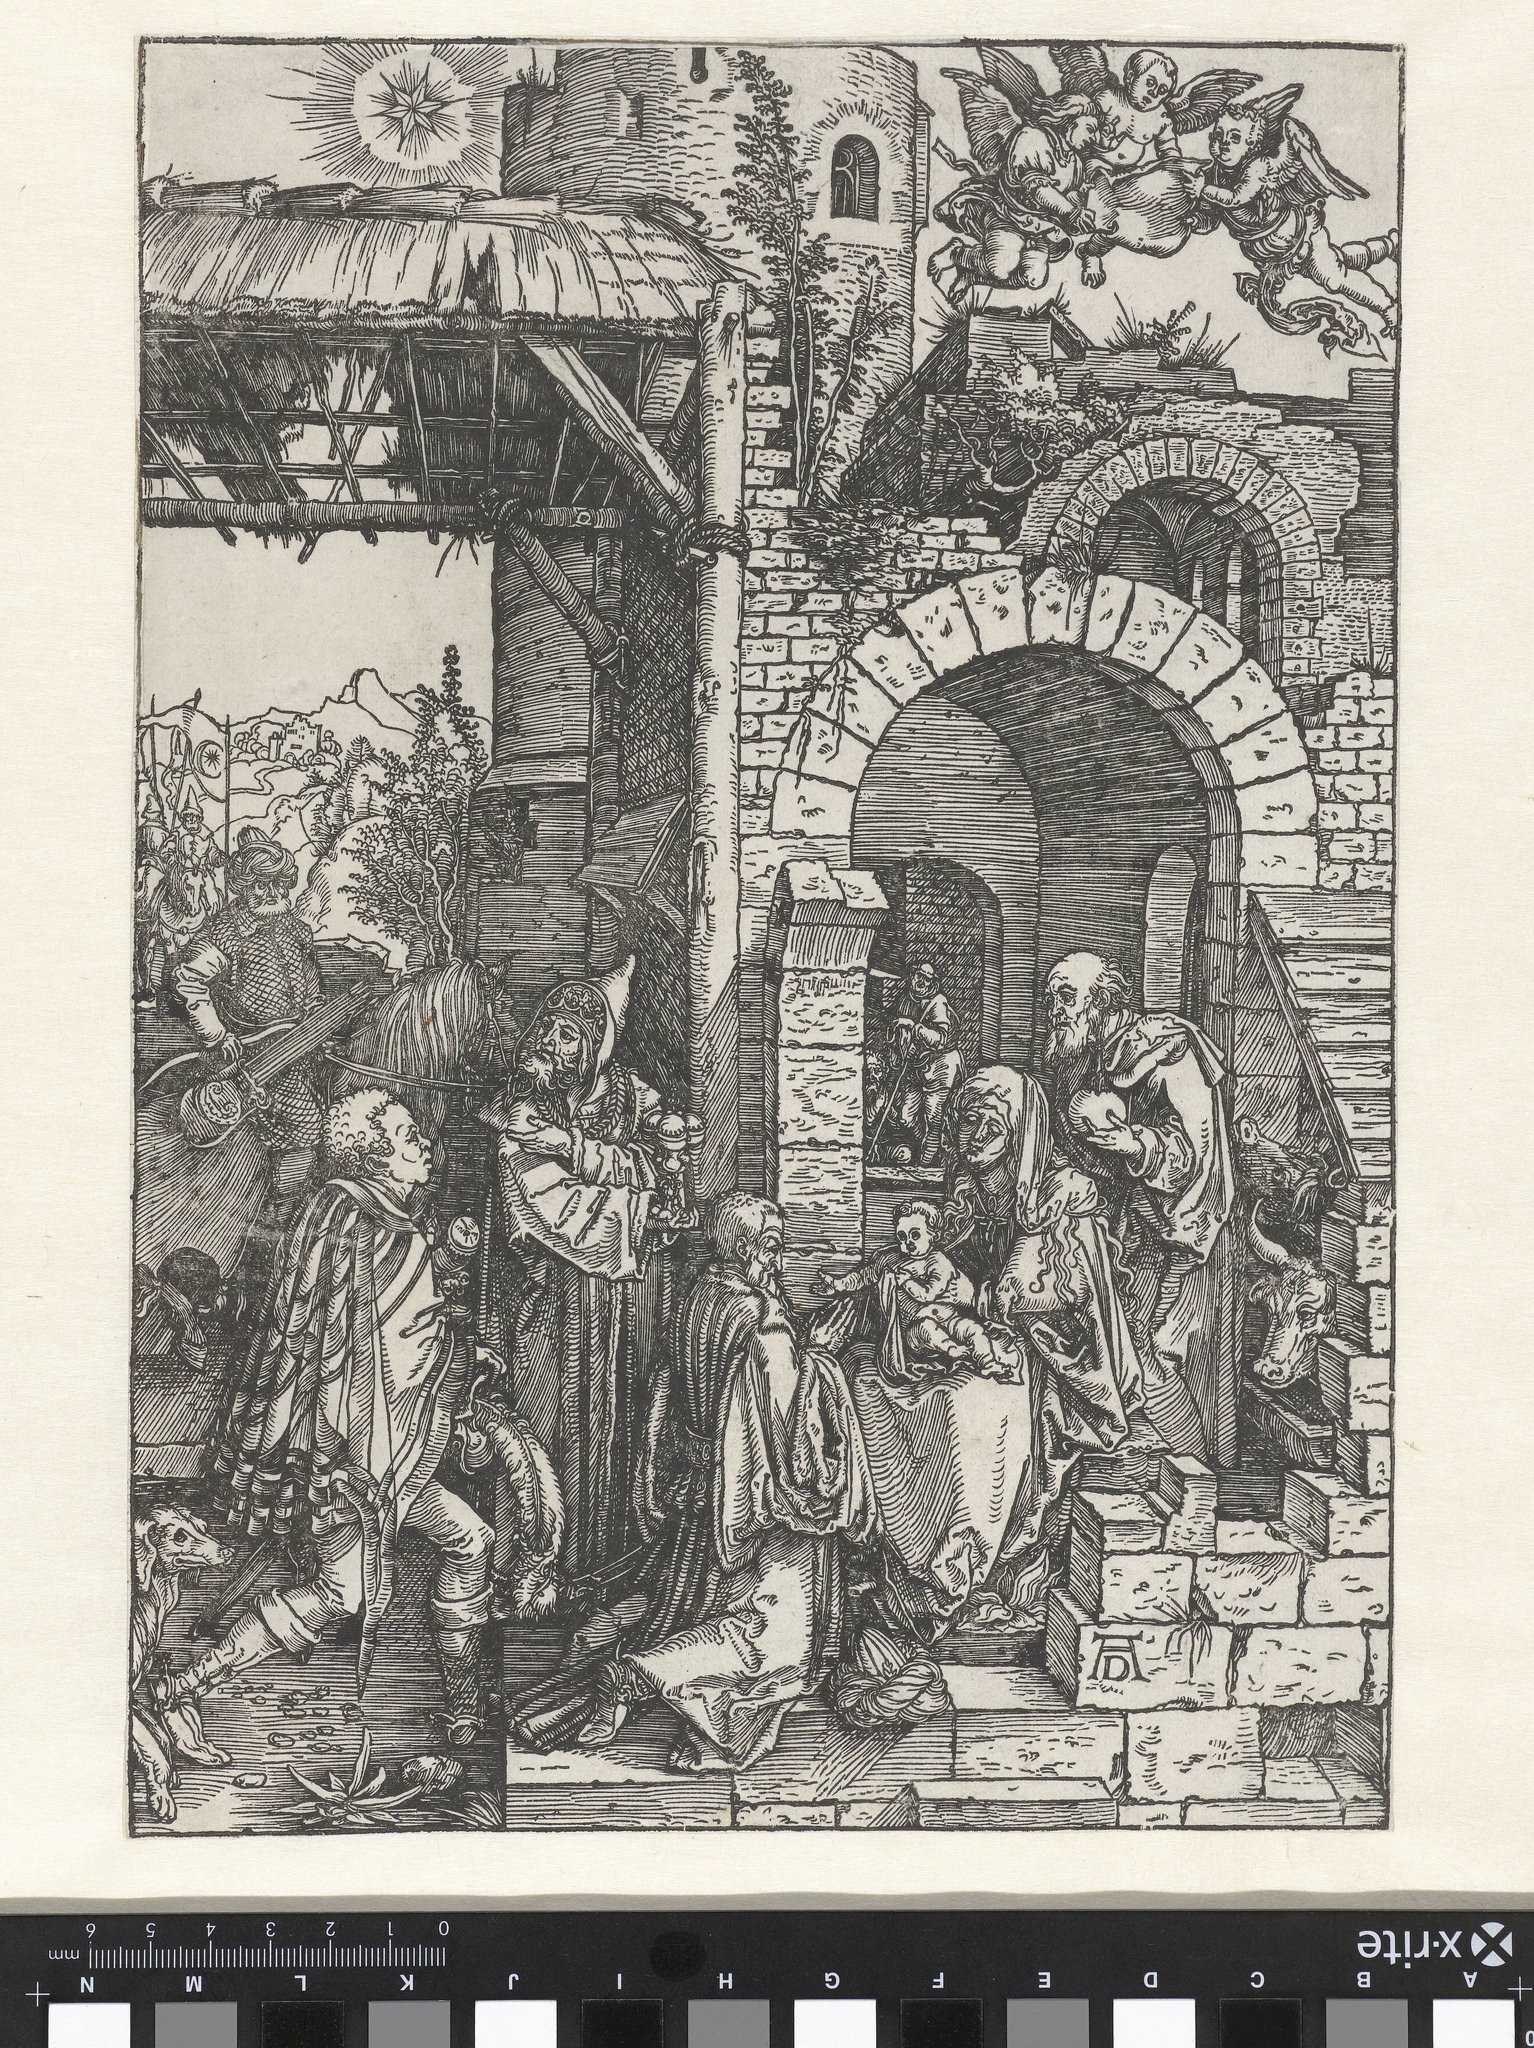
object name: print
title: Leven van Maria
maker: albrecht dürer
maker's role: draughtsman, painter, print maker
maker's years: 1471-1528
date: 1501-1505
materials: paper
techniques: woodcut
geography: nuremberg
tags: adoration of the kings: the wise men present their gifts to the christ-child (gold, frankincense and myrrh)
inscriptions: collector's mark: Lugt 2228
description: Maria zit met het Christuskind op schoot bij de ingang van een vervallen gebouw. Achter haar staat Jozef. De drie koningen of wijzen uit het Oosten bieden Christus hun geschenken aan. Deze prent is onderdeel van een serie van 20 prenten, bestaand uit een titelprent en 19 prenten met scènes uit het leven van Maria.